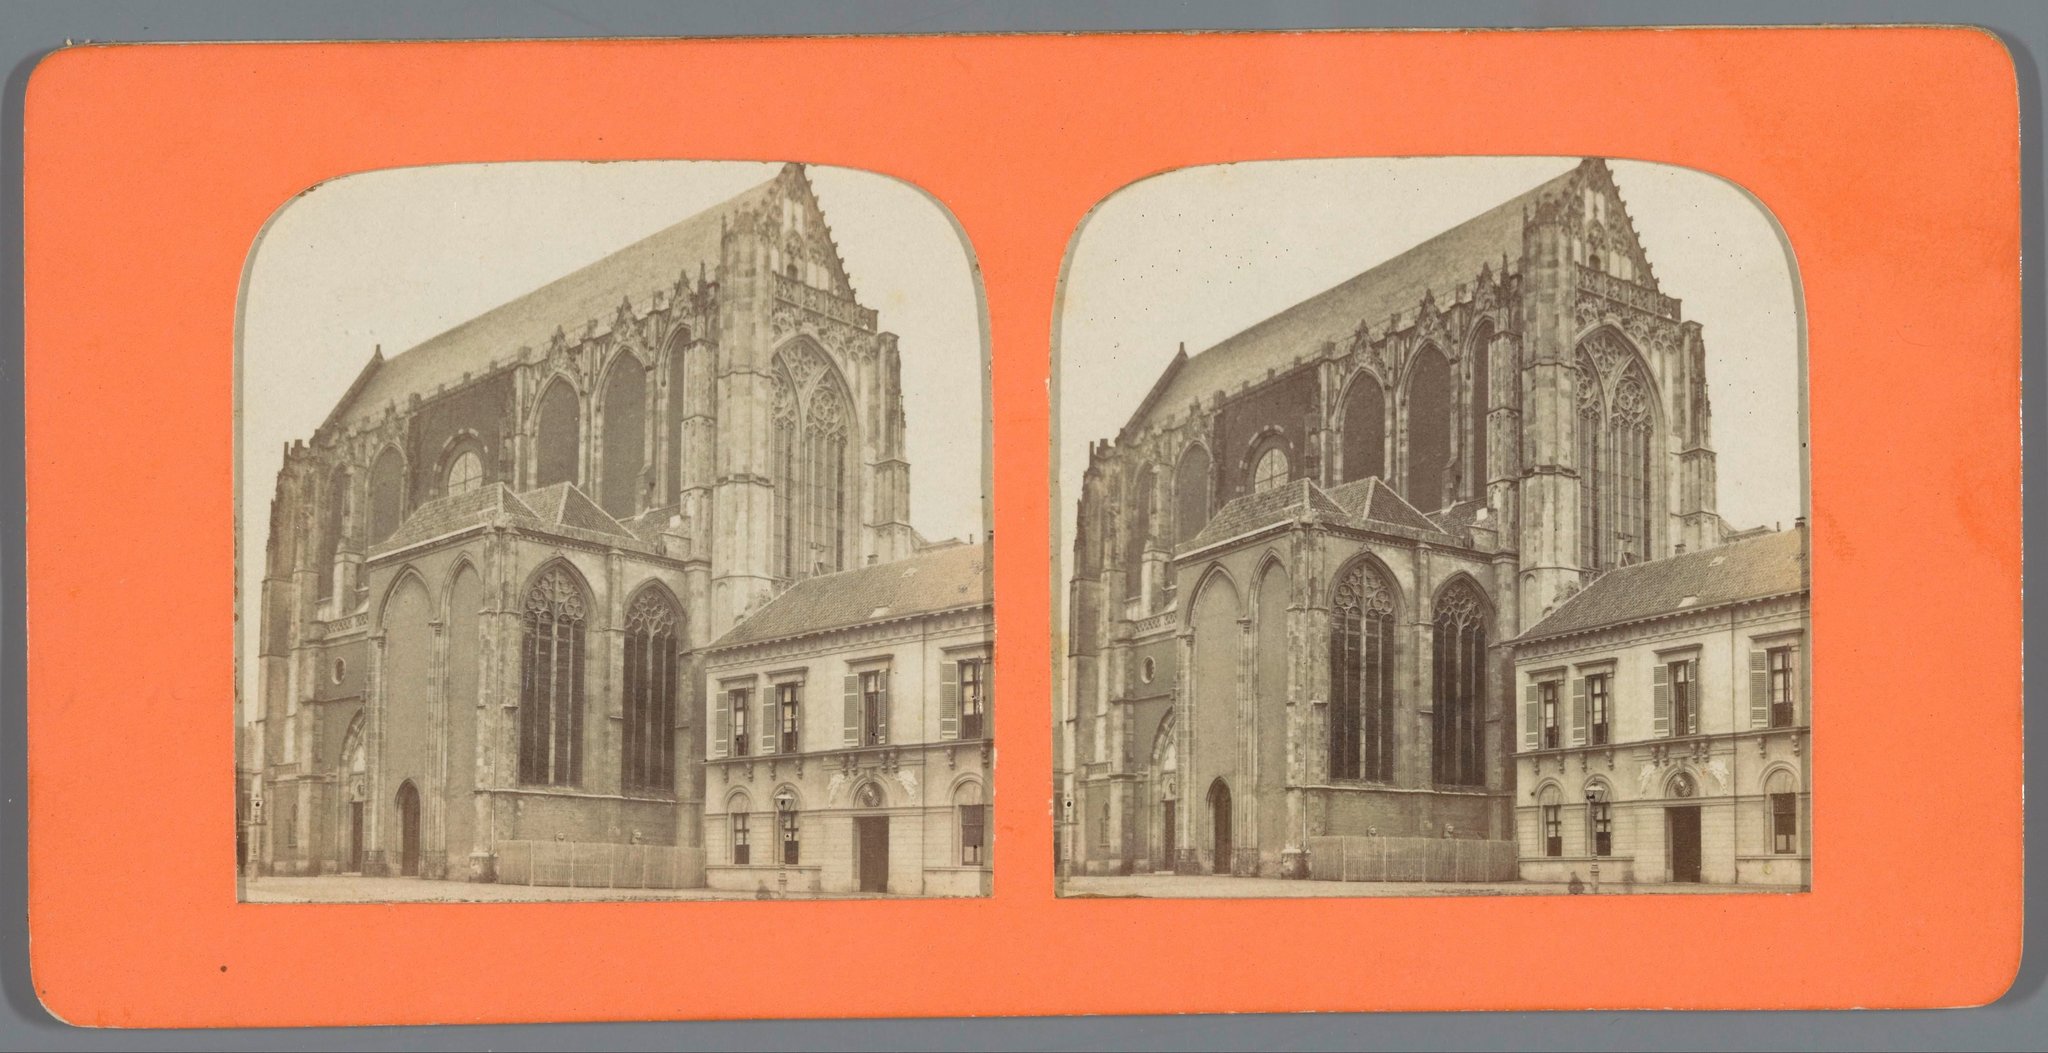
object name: tissue stereograph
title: Utrecht, La Cathédrale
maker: Anonymous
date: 1855-1875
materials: cardboard, paper, photographic support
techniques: albumen print, cutting, hand coloring, perforating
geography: utrecht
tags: church (exterior)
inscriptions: number: ‘No. 2237’